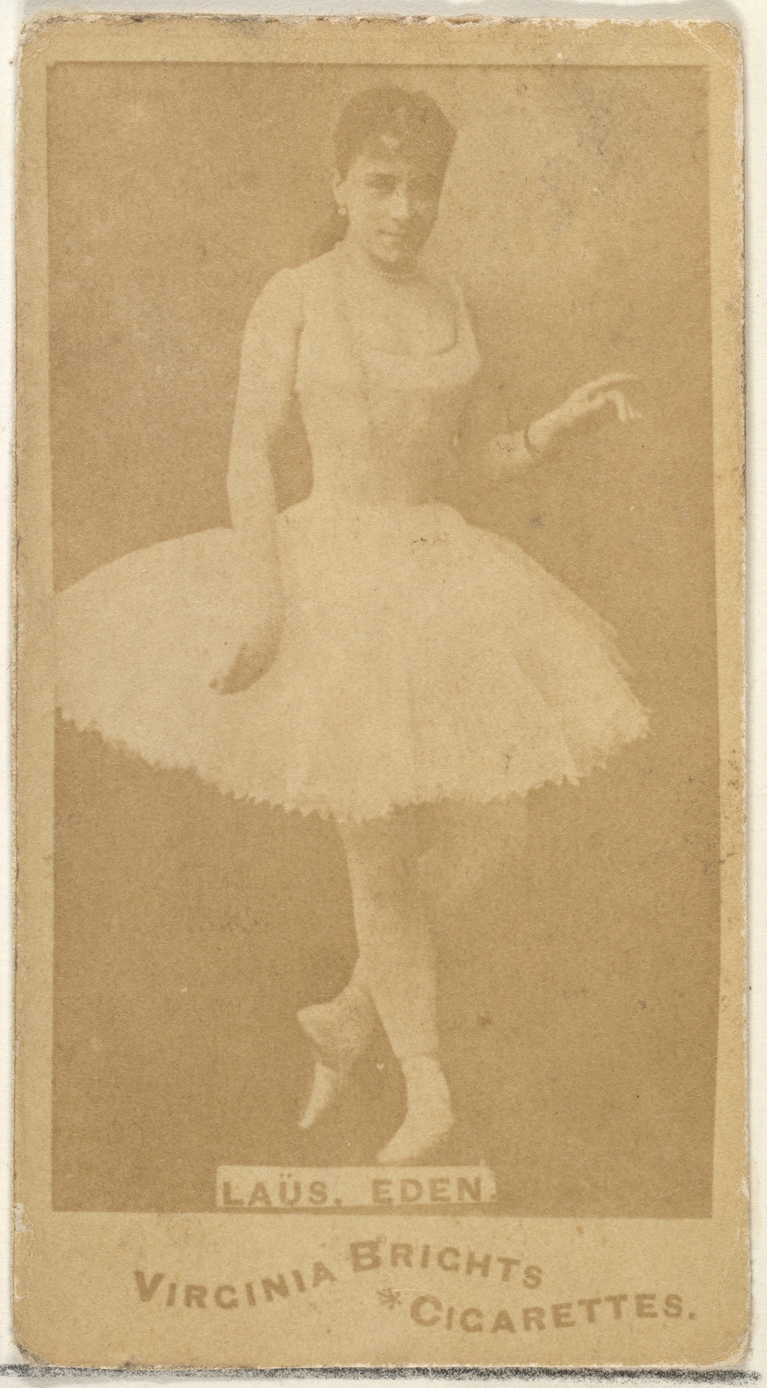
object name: photograph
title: Laus, Eden, from the Actors and Actresses series (N45, Type 1) for Virginia Brights Cigarettes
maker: allen & ginter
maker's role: publisher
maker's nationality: american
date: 1888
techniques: albumen silver print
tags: portraits,women,actresses